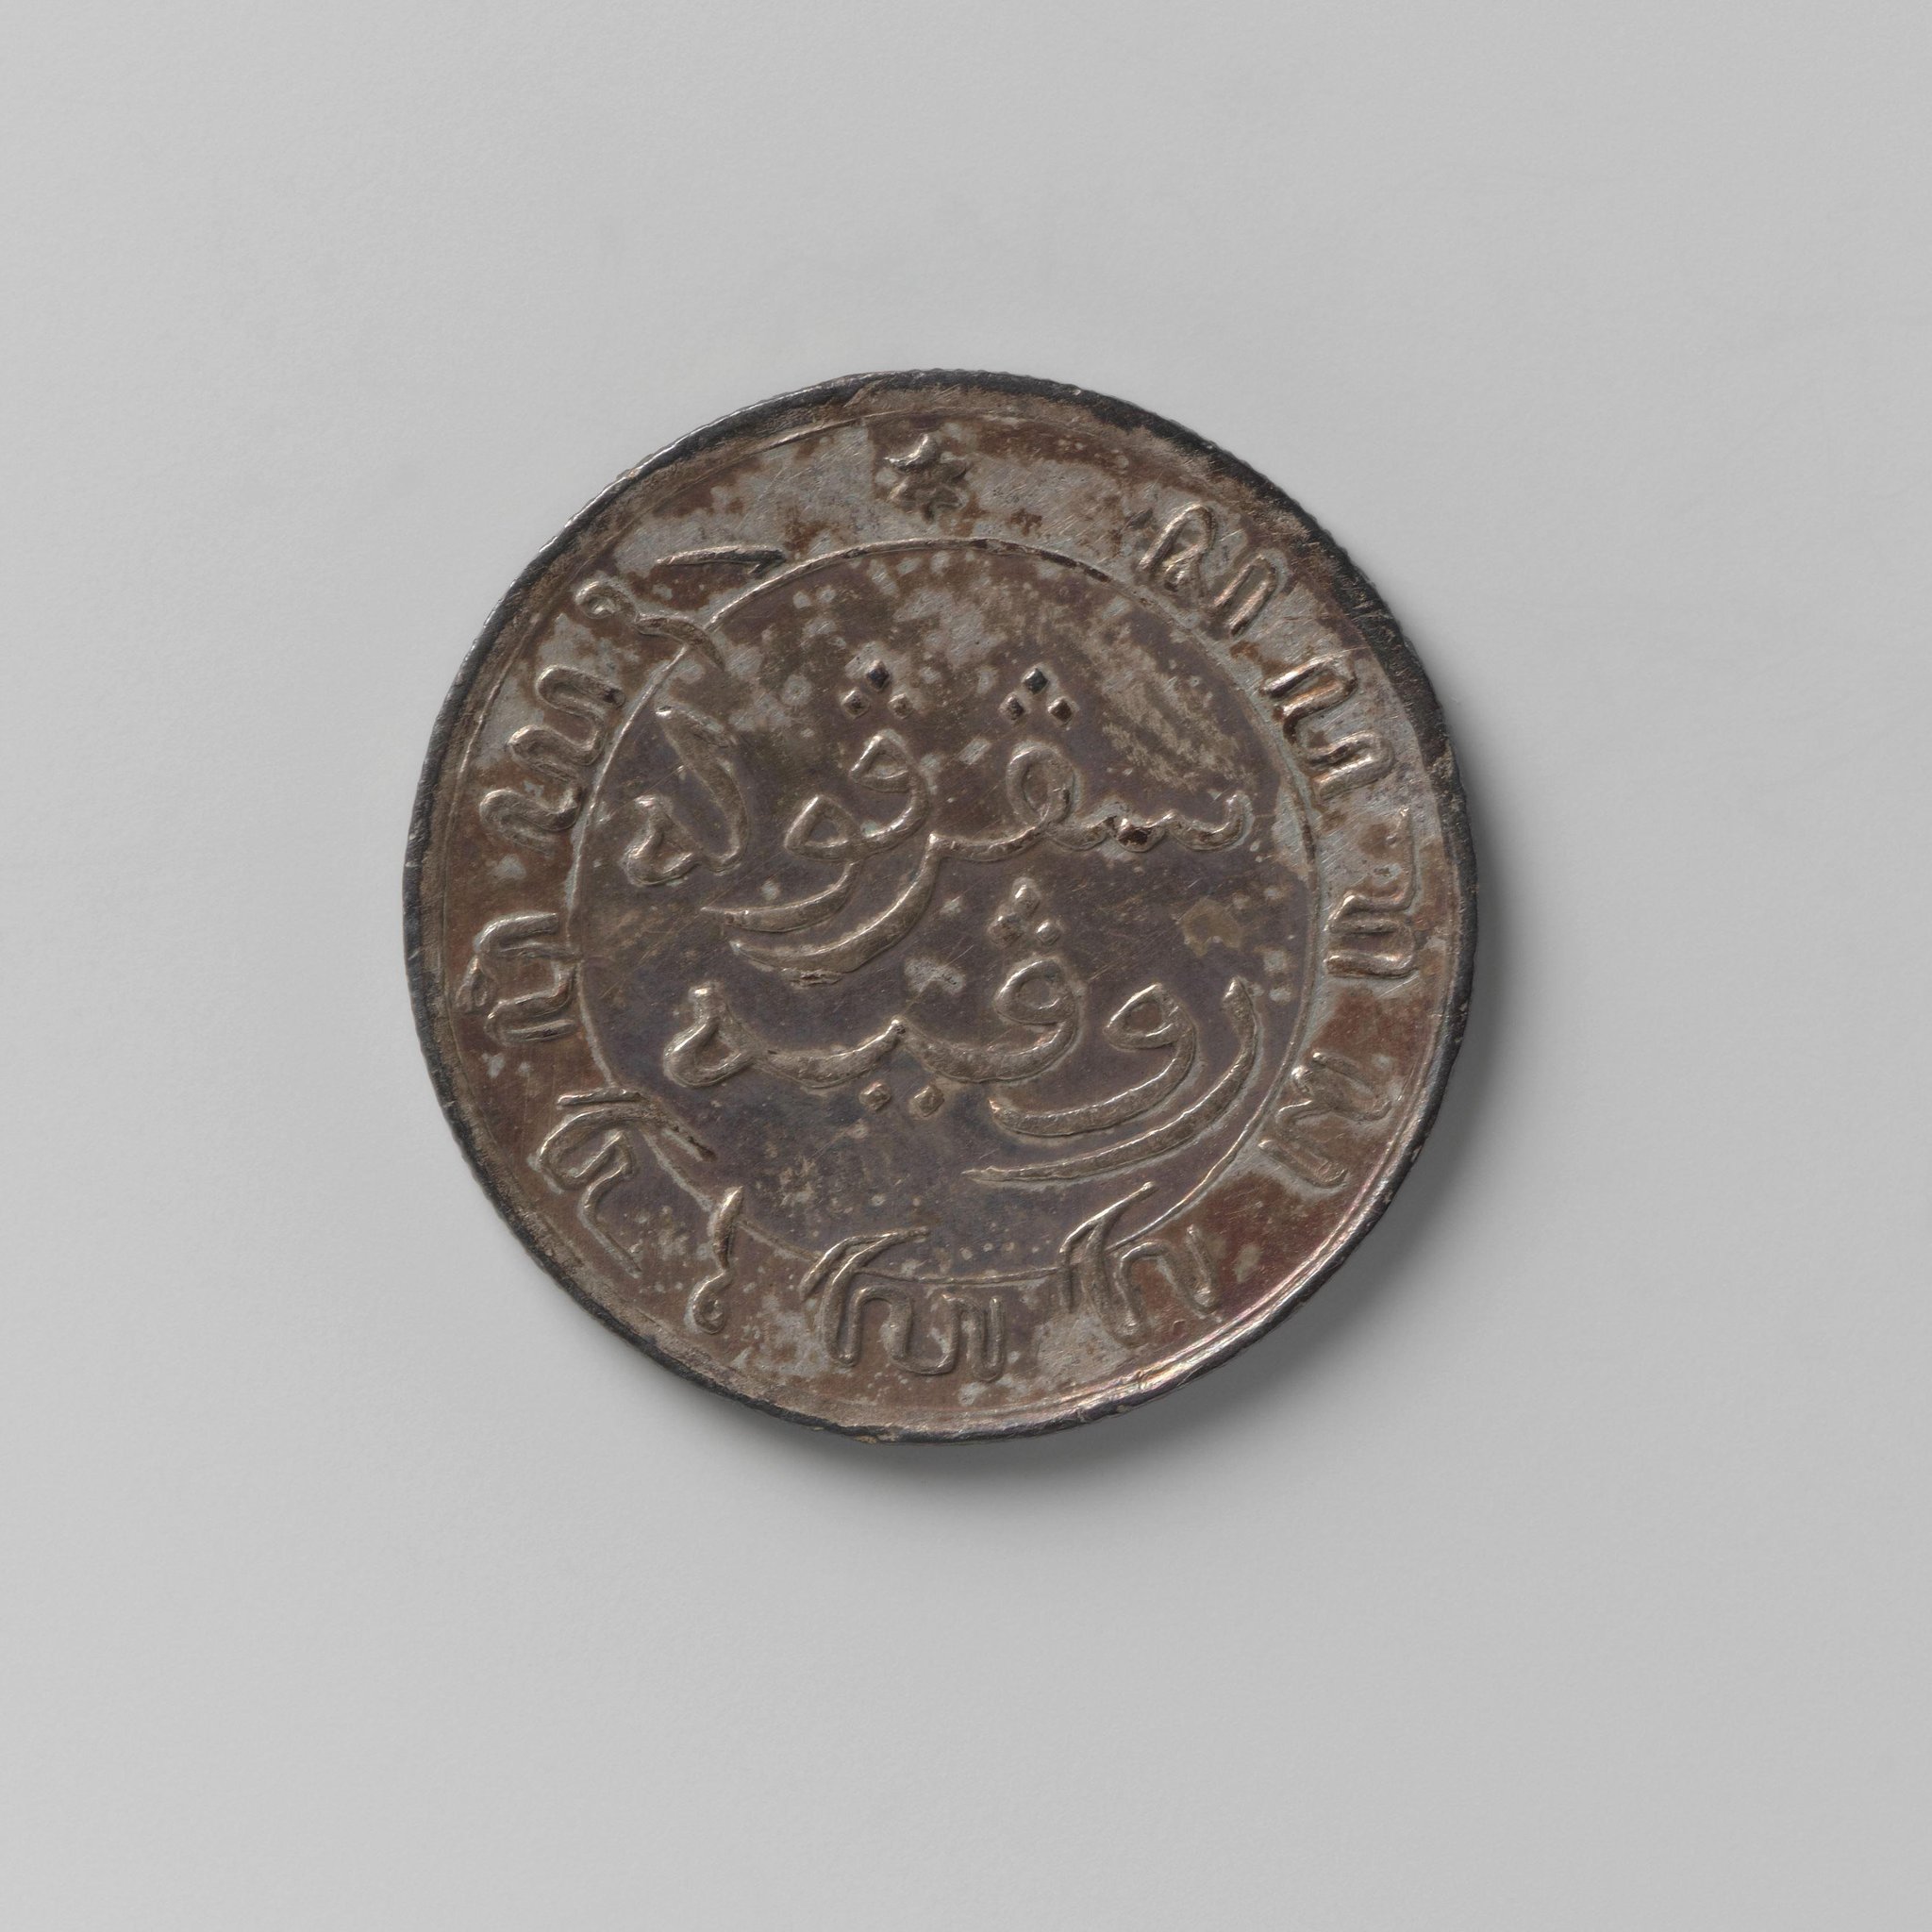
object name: coin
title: Nederlands Indië, 1/10 gulden, 1857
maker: willem iii (koning der nederlanden)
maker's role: koning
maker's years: 1817-1890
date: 1857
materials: silver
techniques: striking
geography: utrecht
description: Zilveren munt. Voorzijde: tussen waarde-aanduiding 1/10 G gekroond rijkswapenschild. Boven kroon landsaanduiding en onder wapenschild jaartal. Keerzijde: tweeregelig Maleis opschrift in Arabische tekens, waaromheen omschrift in het Javaans. Kartelrand.